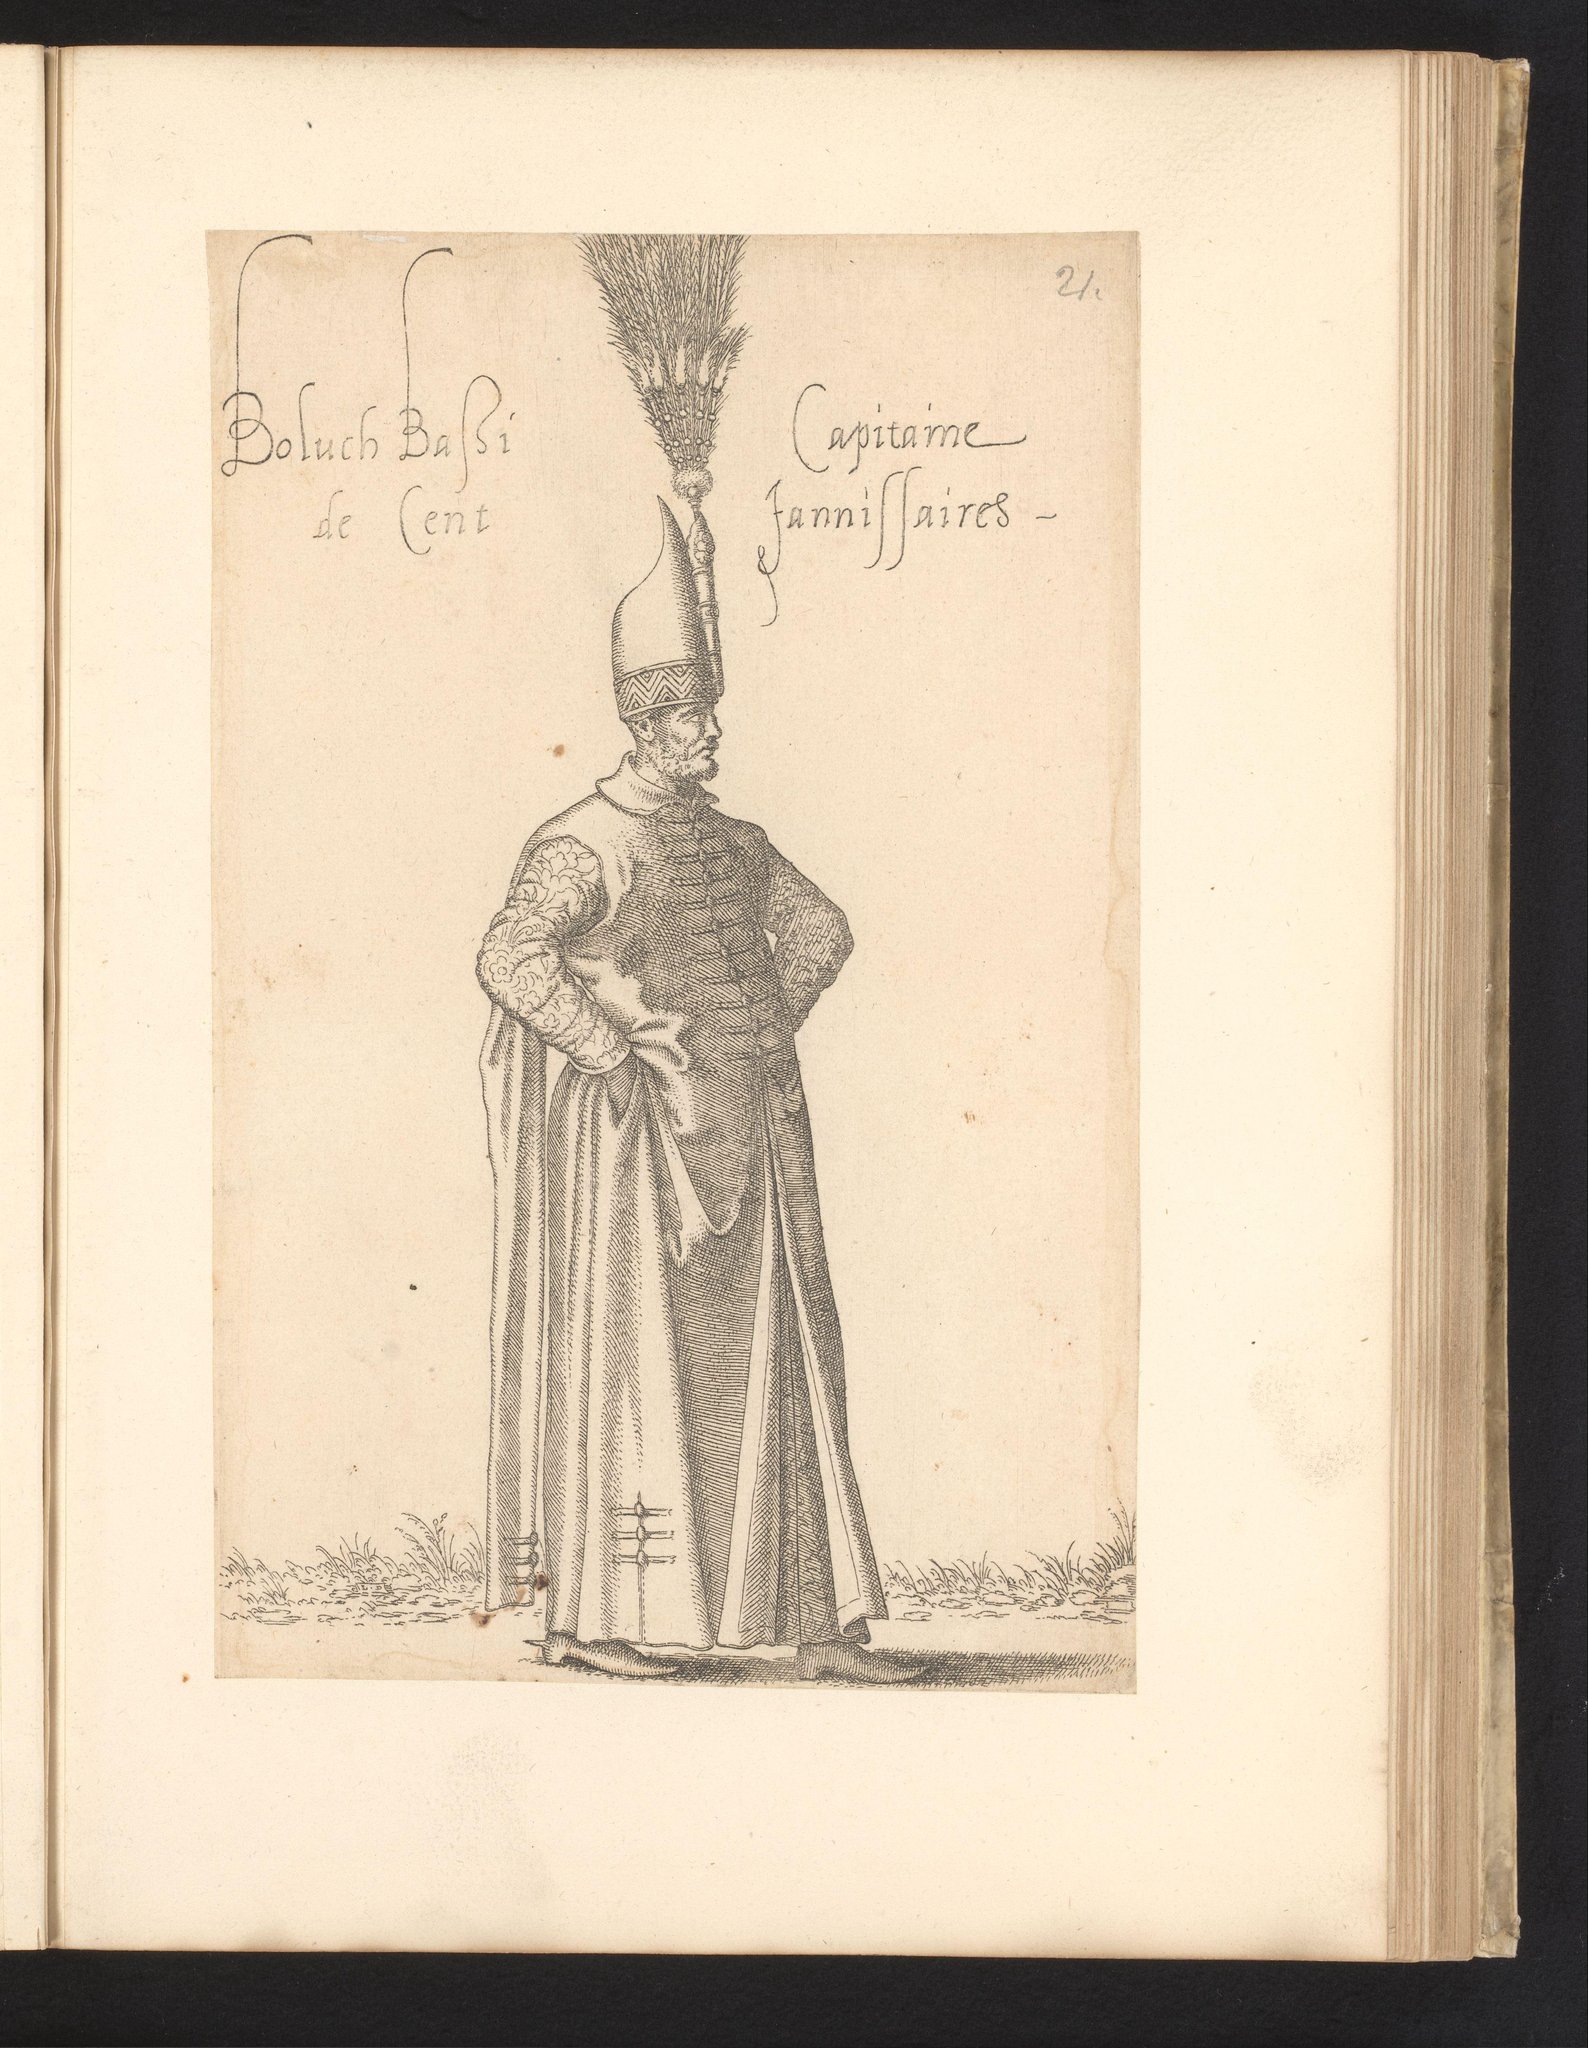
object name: album leaf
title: Boluch Bassi, capitaine de cent jannisaires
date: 1555-1568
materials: paper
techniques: etching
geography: lyon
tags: commander-in-chief, general, marshal, asiatic races and peoples: turks (+ costume)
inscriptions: collector's mark: Lugt 2228, collector's mark: Lugt 2760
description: Prent uit: Nicolay, Nicolas de. Les quatre premiers livres des navigations et pérégrinations orientales, de N. de Nicolay, (...) Avec les figures au naturel tant d'hommes que de femmes selon la diversité des nations, & de leur port, maintien & habitz. Lyon: Guillaume (I) Rouille, 1568.